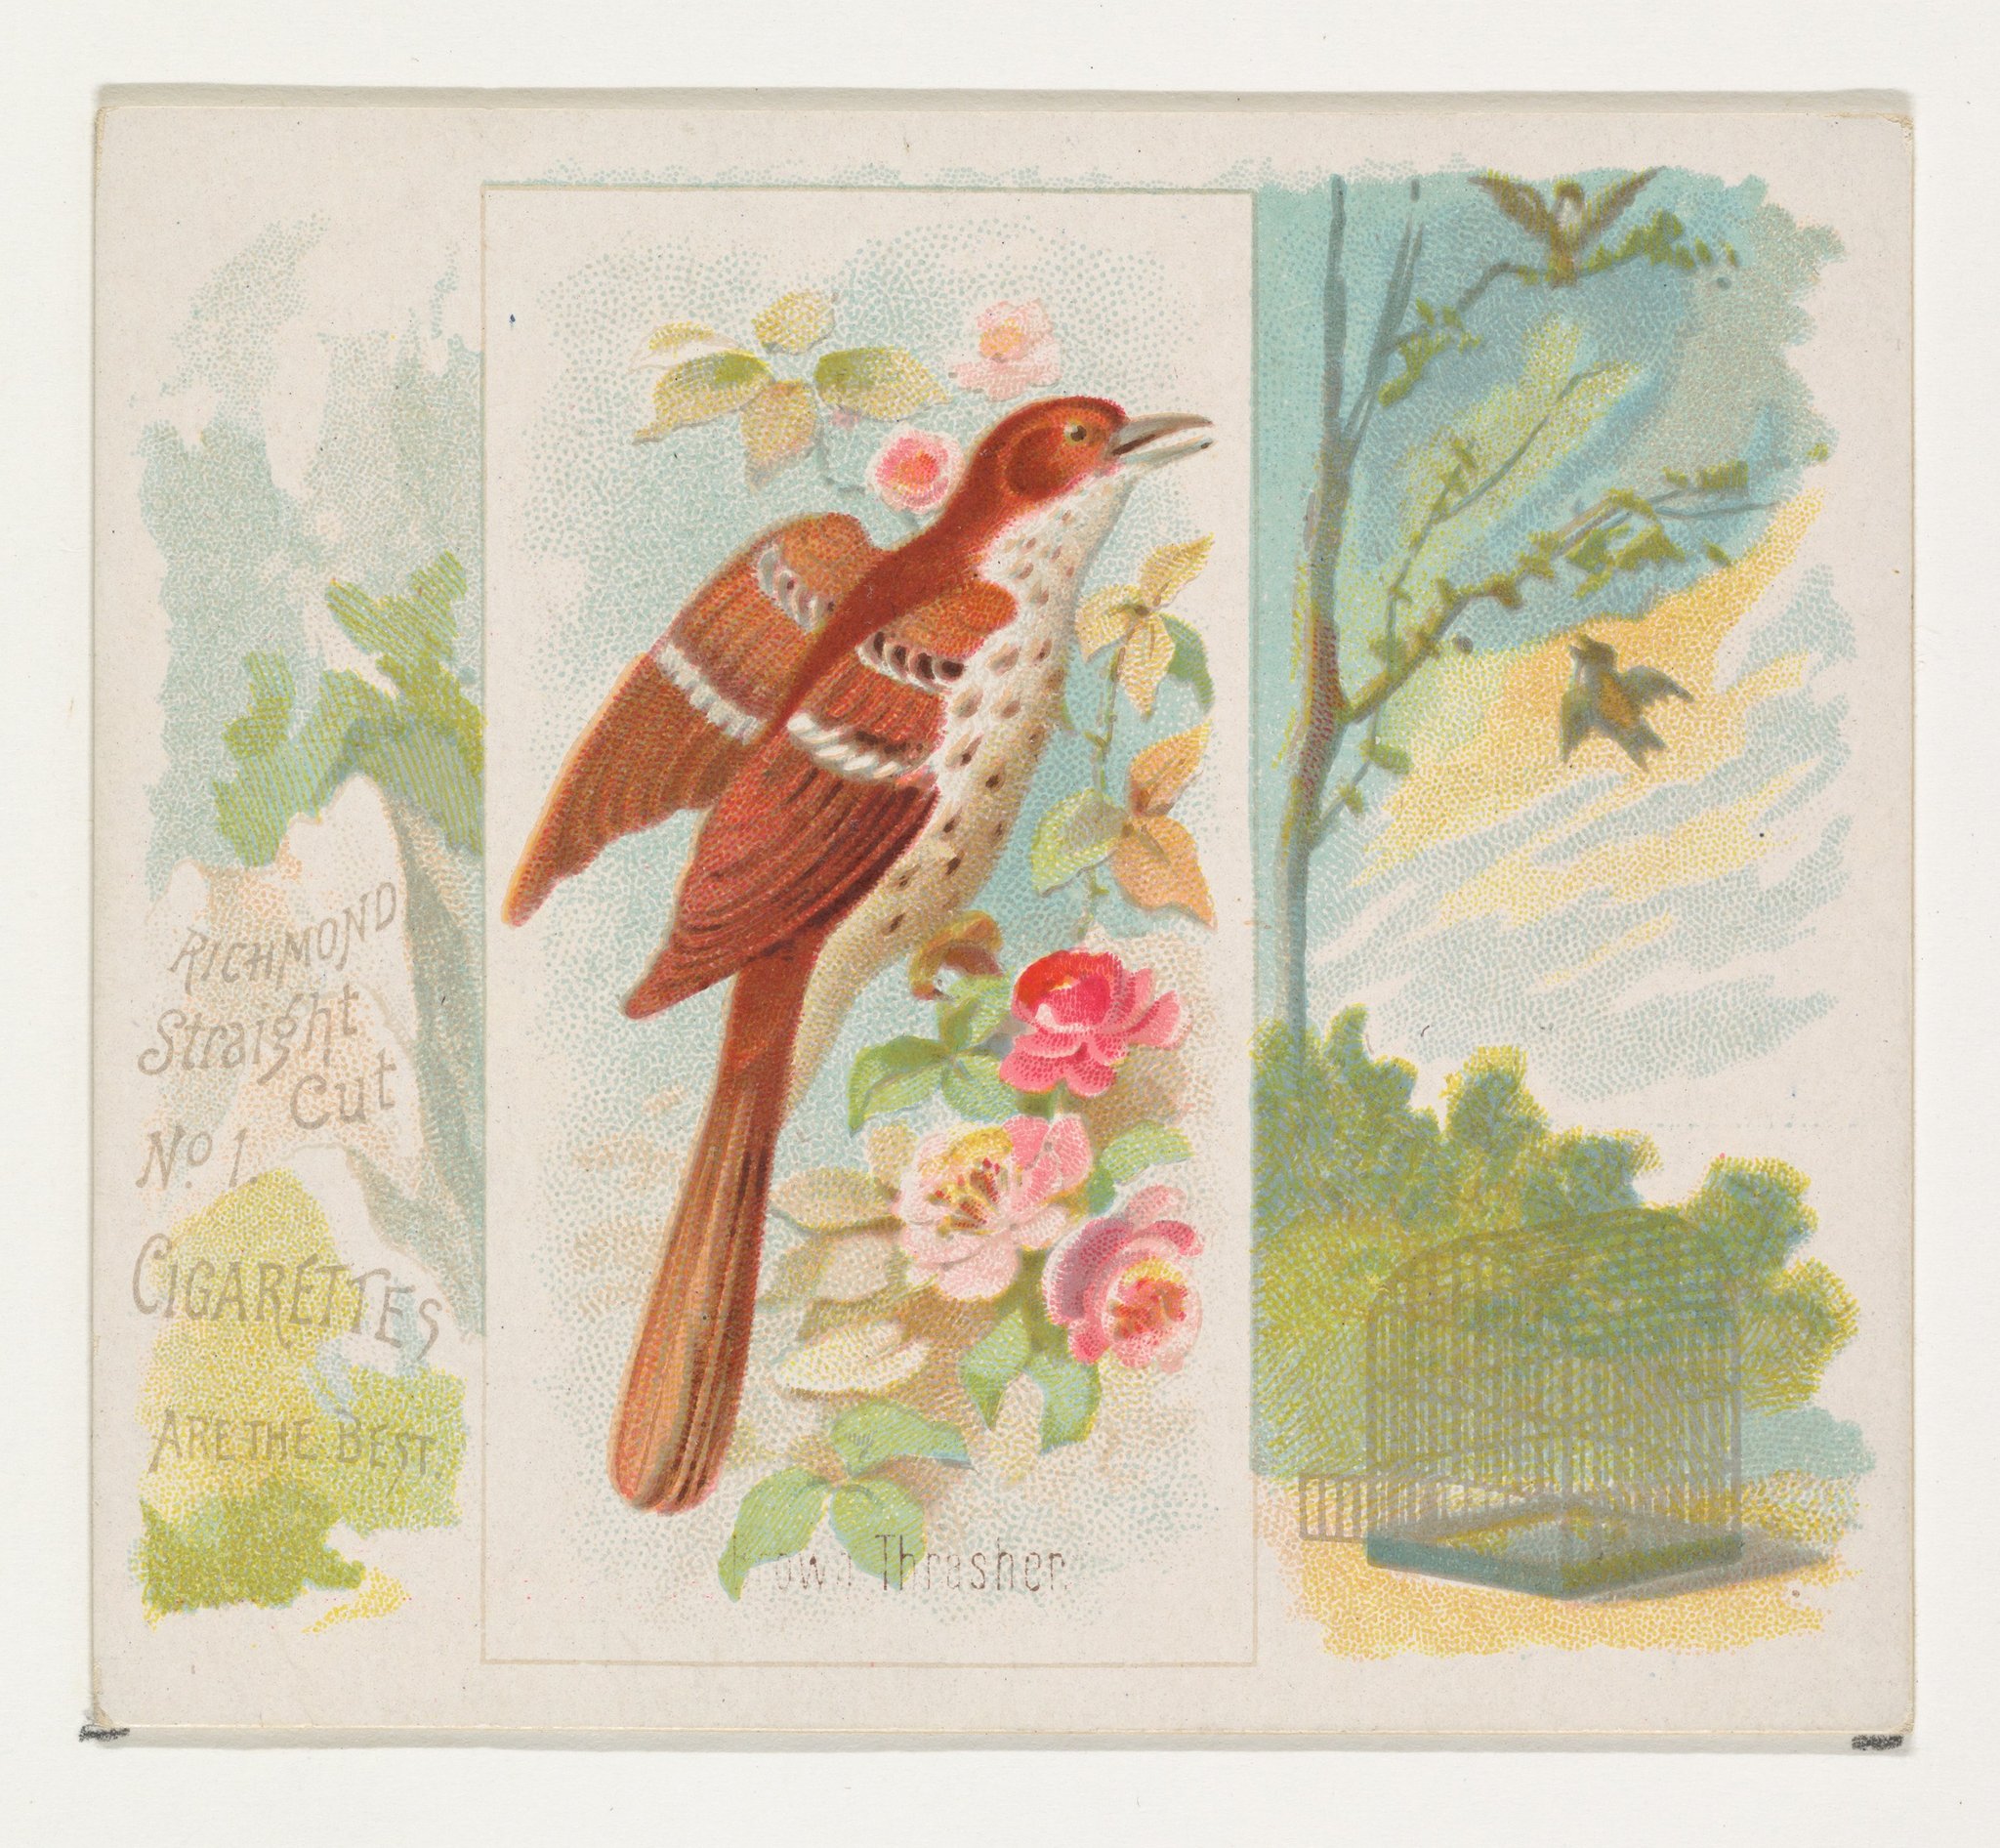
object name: print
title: Brown Thrasher, from the Song Birds of the World series (N42) for Allen & Ginter Cigarettes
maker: allen & ginter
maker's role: publisher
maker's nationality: american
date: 1890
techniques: color lithograph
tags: birds